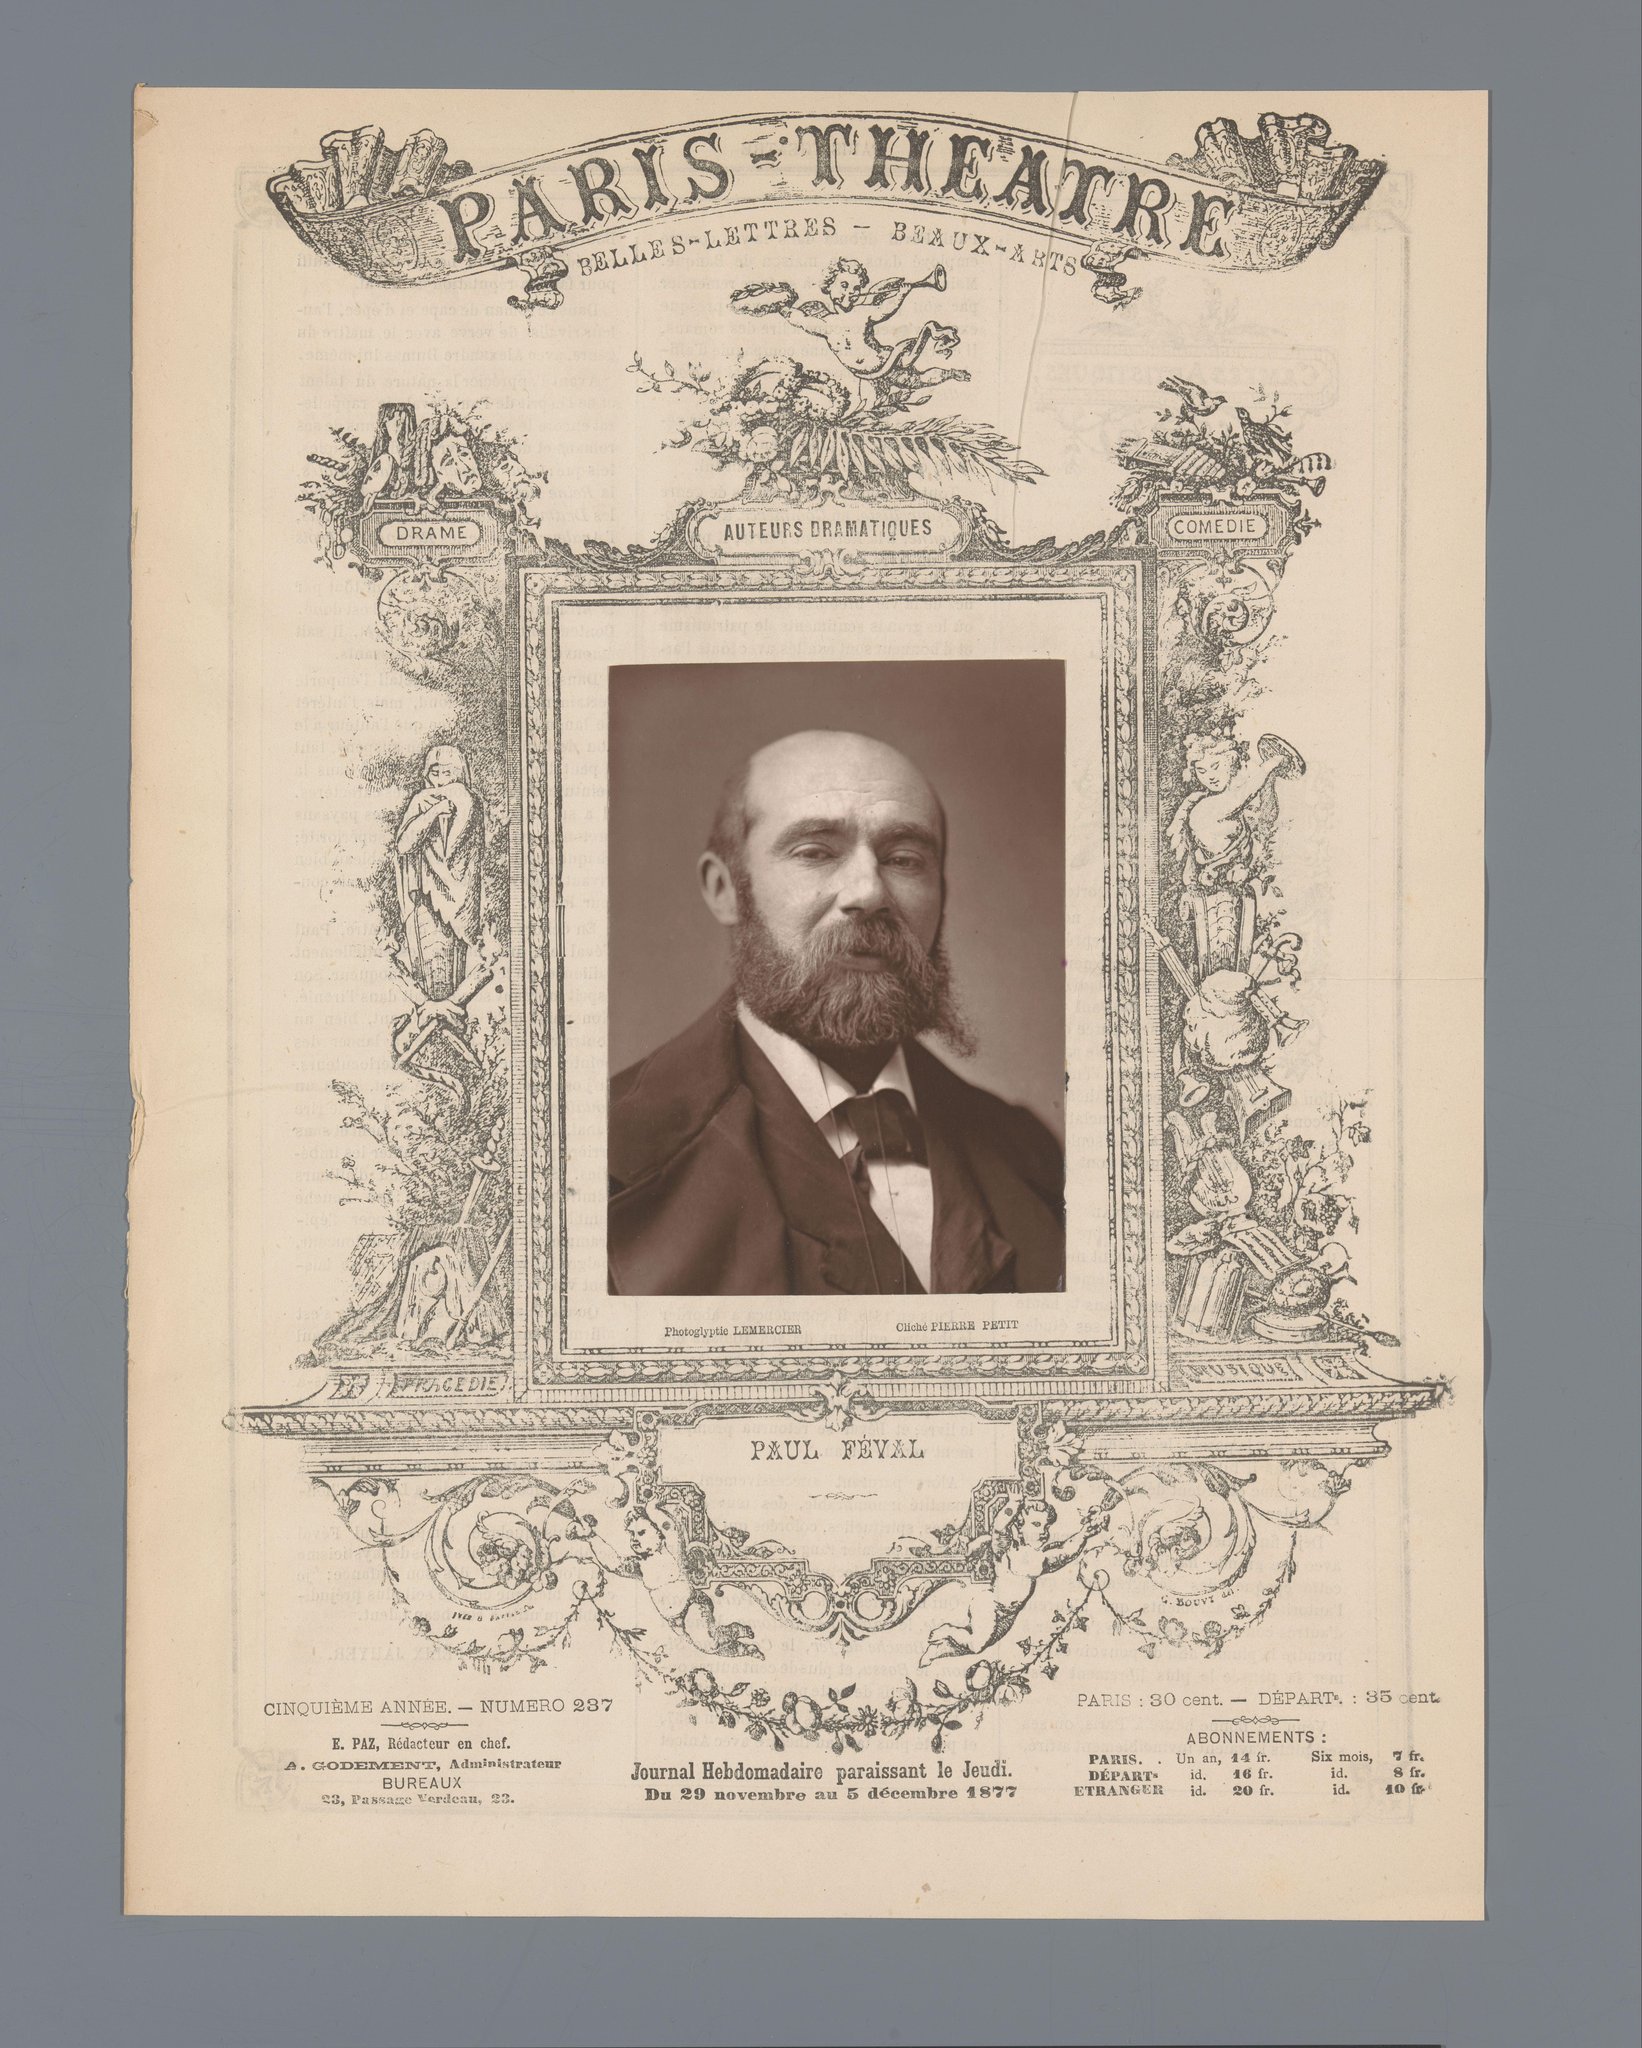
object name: photomechanical print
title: Paul Féval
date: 1872-1879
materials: paper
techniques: woodburytype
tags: paul féval, historical persons